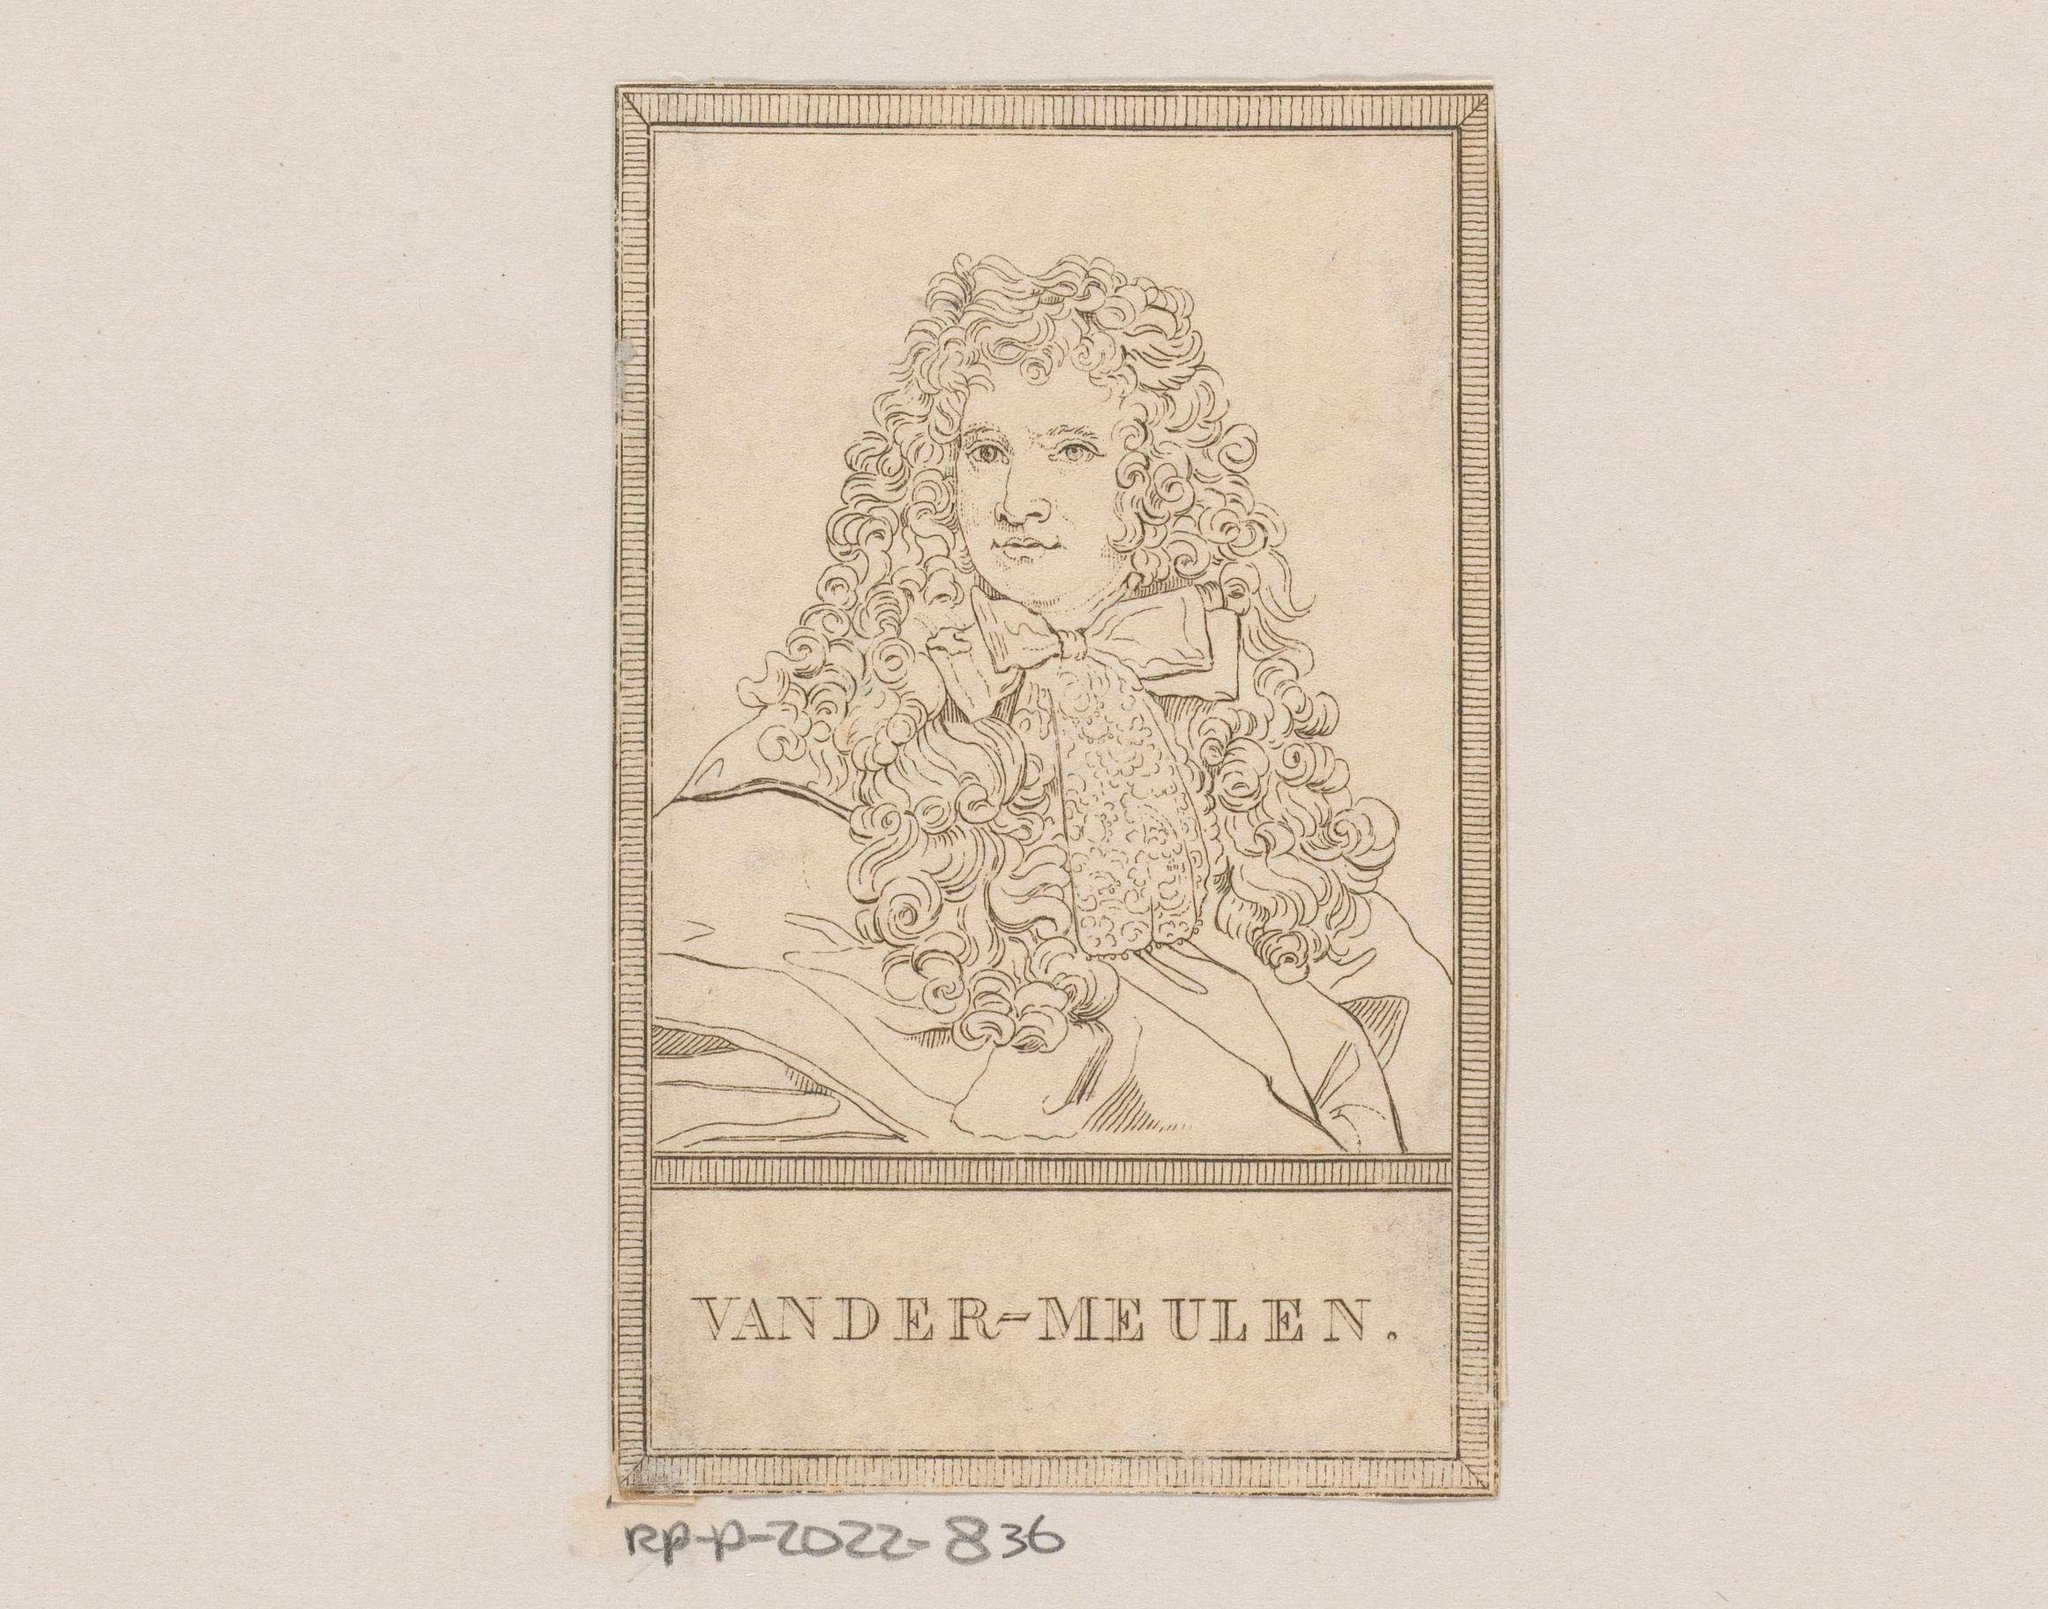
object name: print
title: Portret van Adam Frans van der Meulen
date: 1805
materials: paper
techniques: etching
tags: brussels, paris, painter, draughtsman, publisher, adam frans van der meulen, historical persons, portrait, self-portrait of painter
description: Prent waarschijnlijk uit: Galerie historique des hommes les plus célèbres (...). Parijs: Charles Paul Landon, 1805, dl. 5.